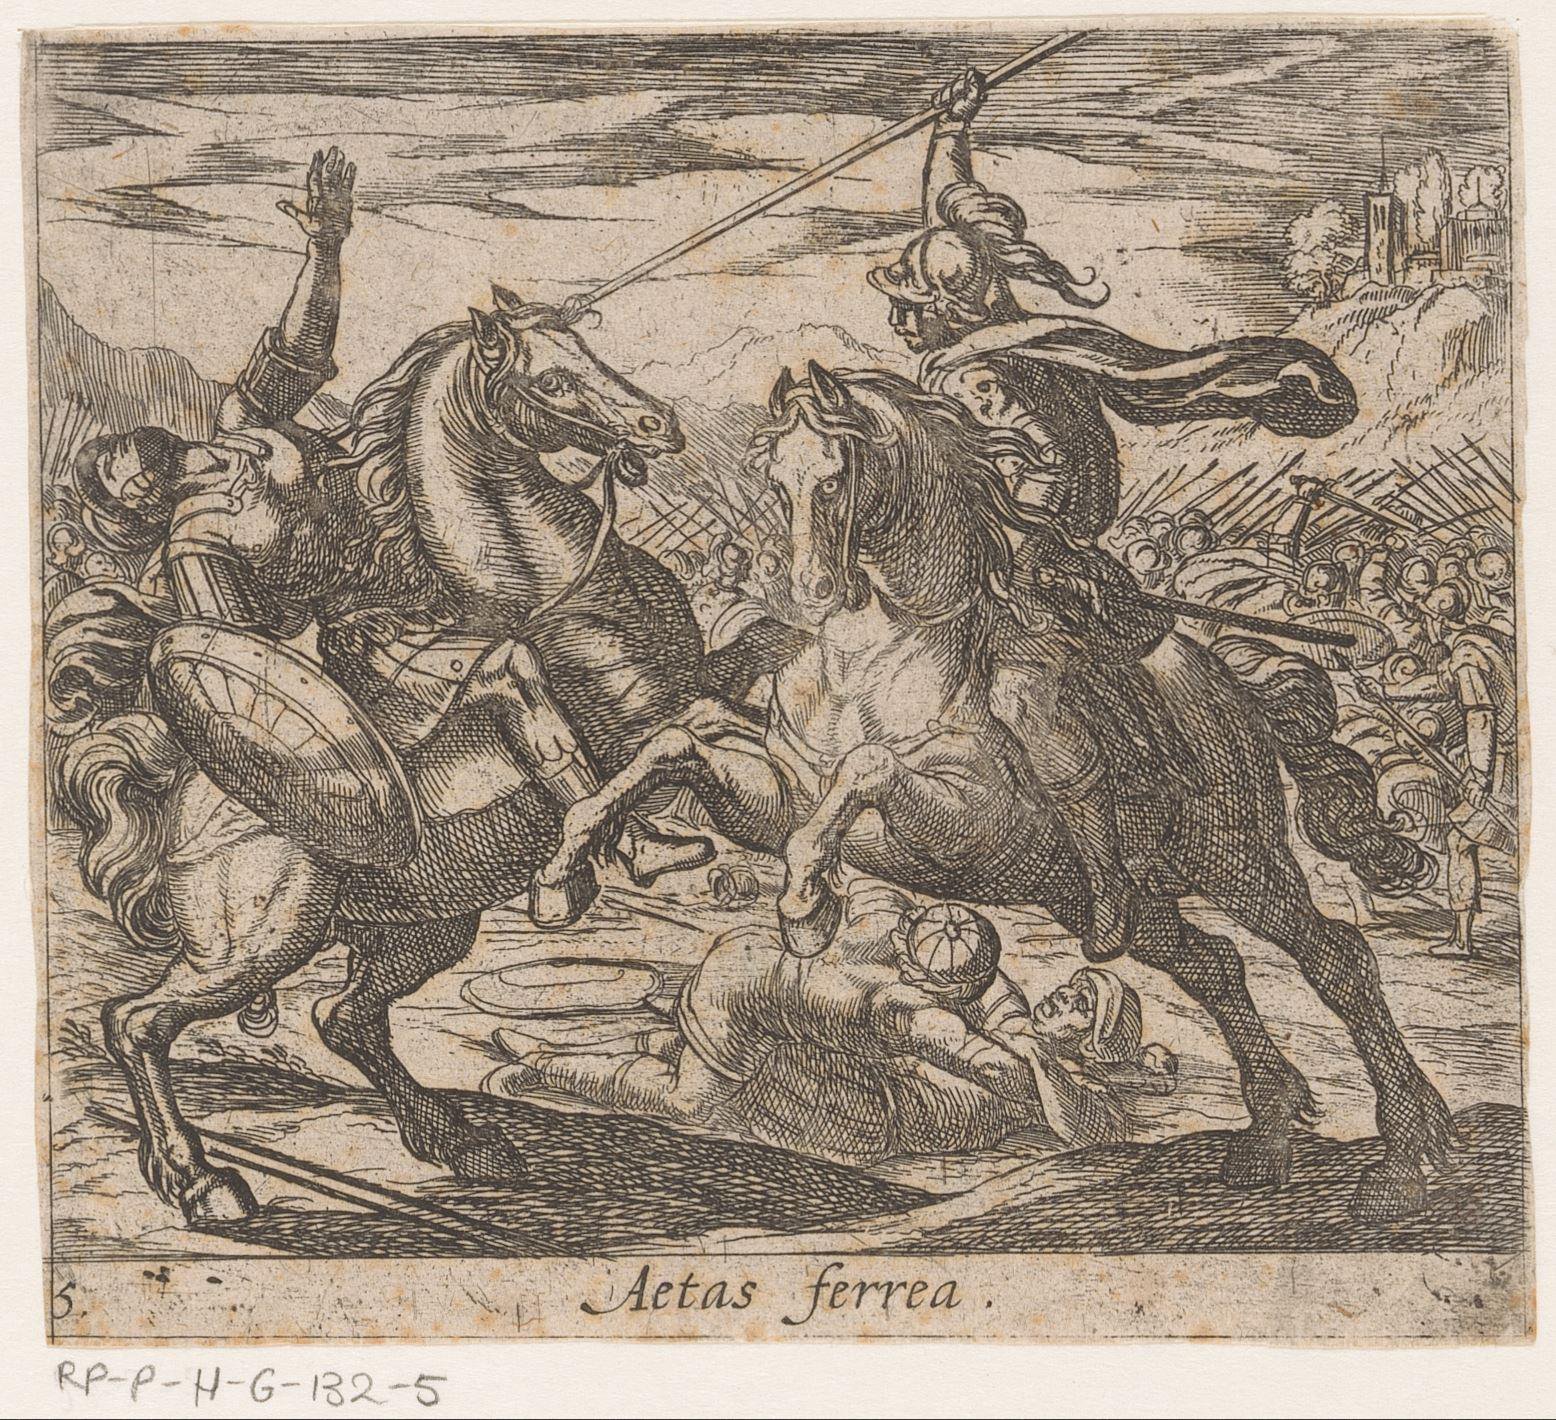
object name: print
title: Metamorphoseon sive transformationum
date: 1606-1638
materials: paper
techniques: etching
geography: italy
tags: the iron age, 'aetas ferrea'; characterized by mars, war and rapine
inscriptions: collector's mark: ‘Hinloopen’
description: Deze prent maakt deel uit van een reeks van 150 prenten (+ titelprent) met voorstellingen van de Metamorfosen van Ovidius.